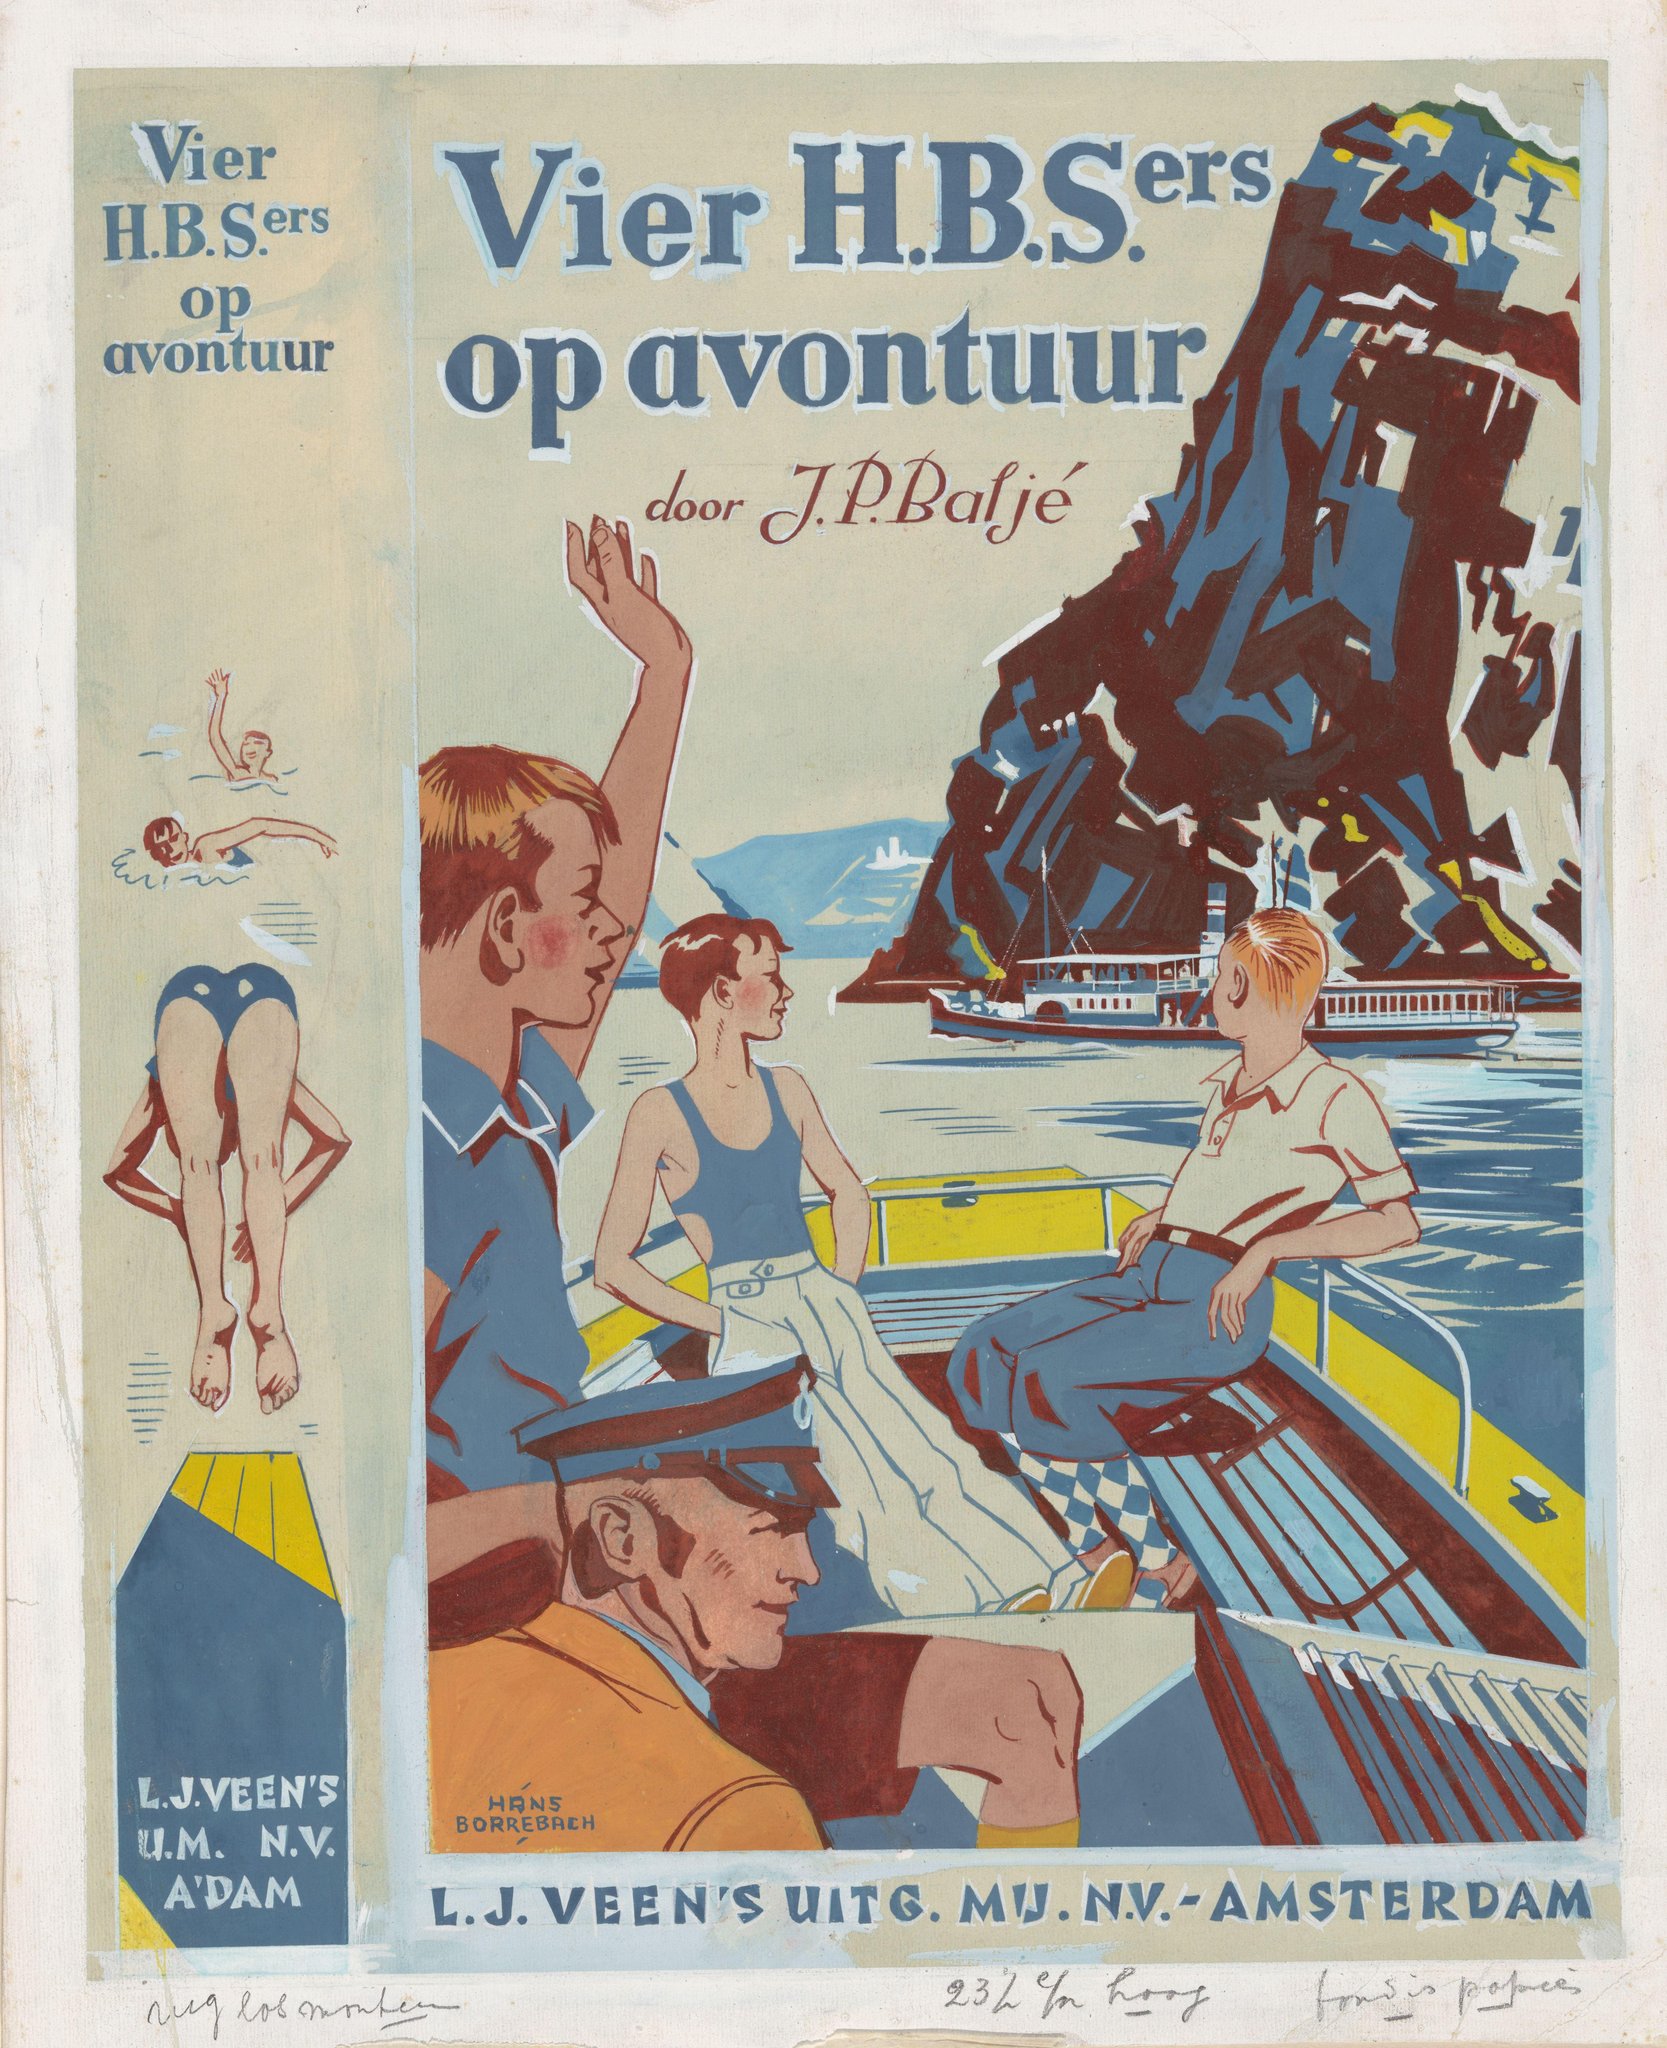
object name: study for binding design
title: Bandontwerp voor: J.P. Baljé, Vier h.b.s.ers op avontuur, 1933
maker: hans borrebach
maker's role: draughtsman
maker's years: 1903-1991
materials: paint, ink, paper, pencil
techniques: brush, pen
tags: diving (movement in water), boy (child between toddler and youth), swimming (sport), traffic on the water, rocks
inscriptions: annotation: ‘rug los monteren/ fond is papier’, :, signature: ‘HANS/ BORREBACH’, collector's mark: Lugt 2228a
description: Drie jongens en een kapitein zitten op een boot die richting een rotsformatie vaart. Aan de voet van de rots ligt een tweede boot op het water. Eén van de jongens aan boord heft zijn linkerhand op. Op de boekrug een jongen die van een duikplank springt en twee zwemmende jongens.